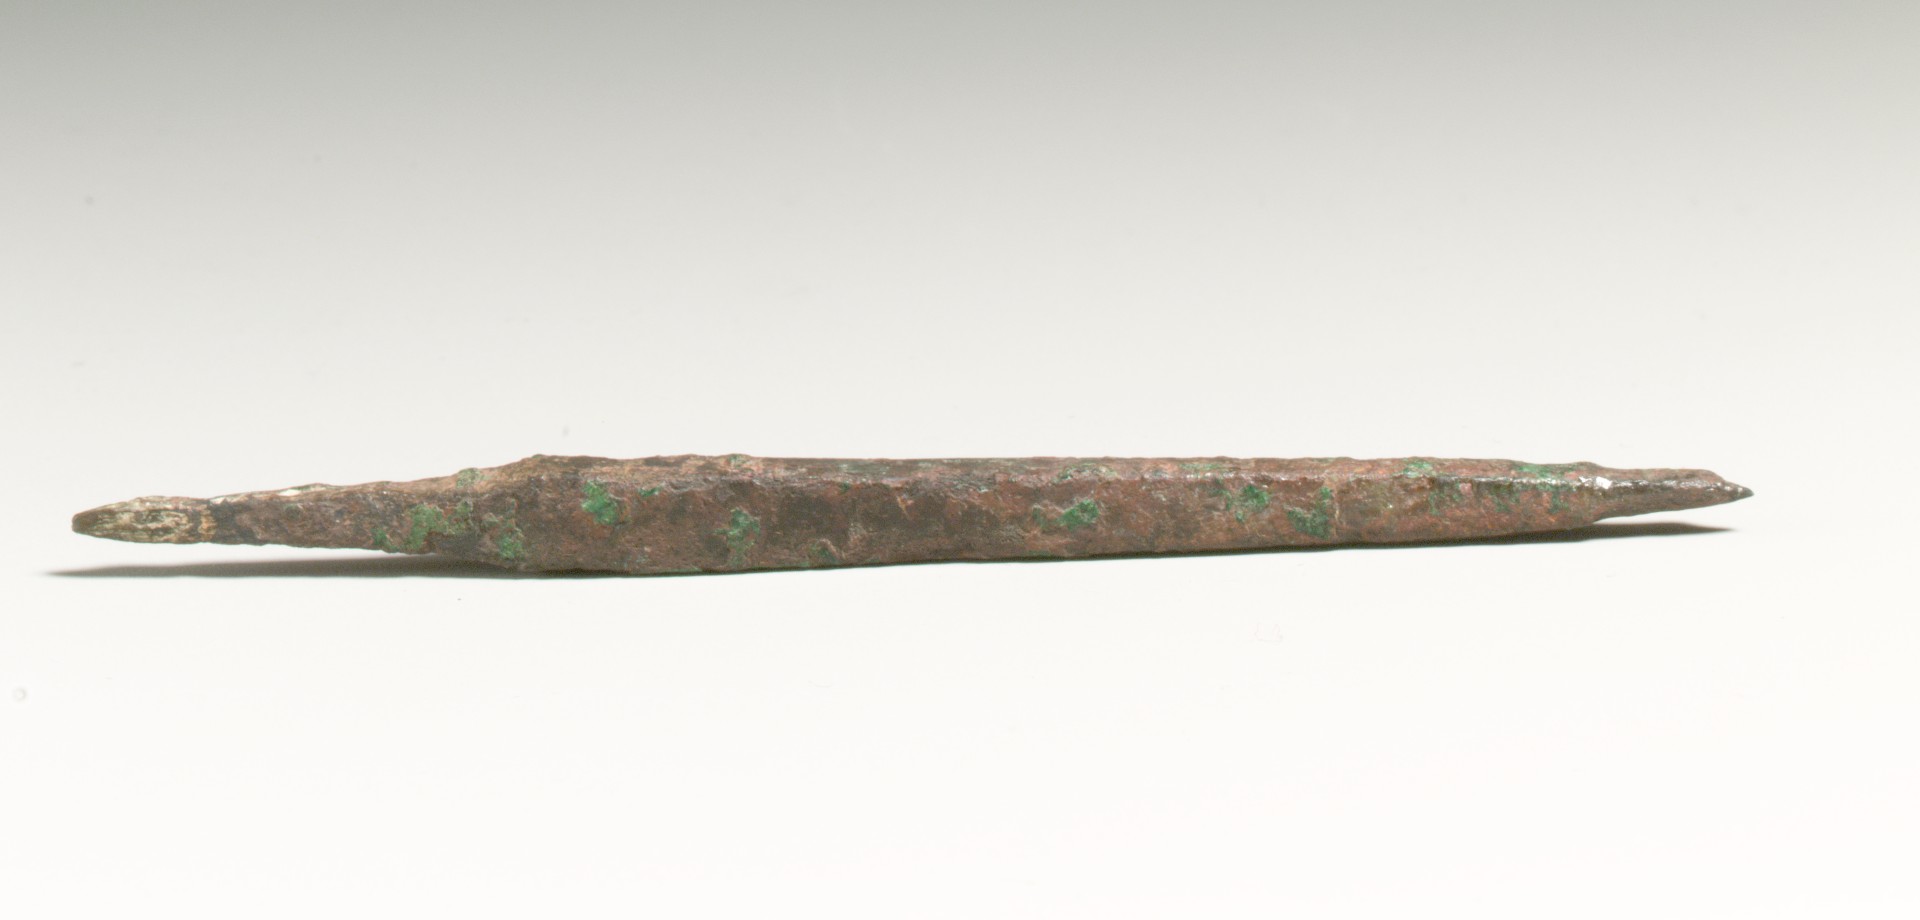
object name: awl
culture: cypriot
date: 3900 BCE-100 CE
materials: bronze